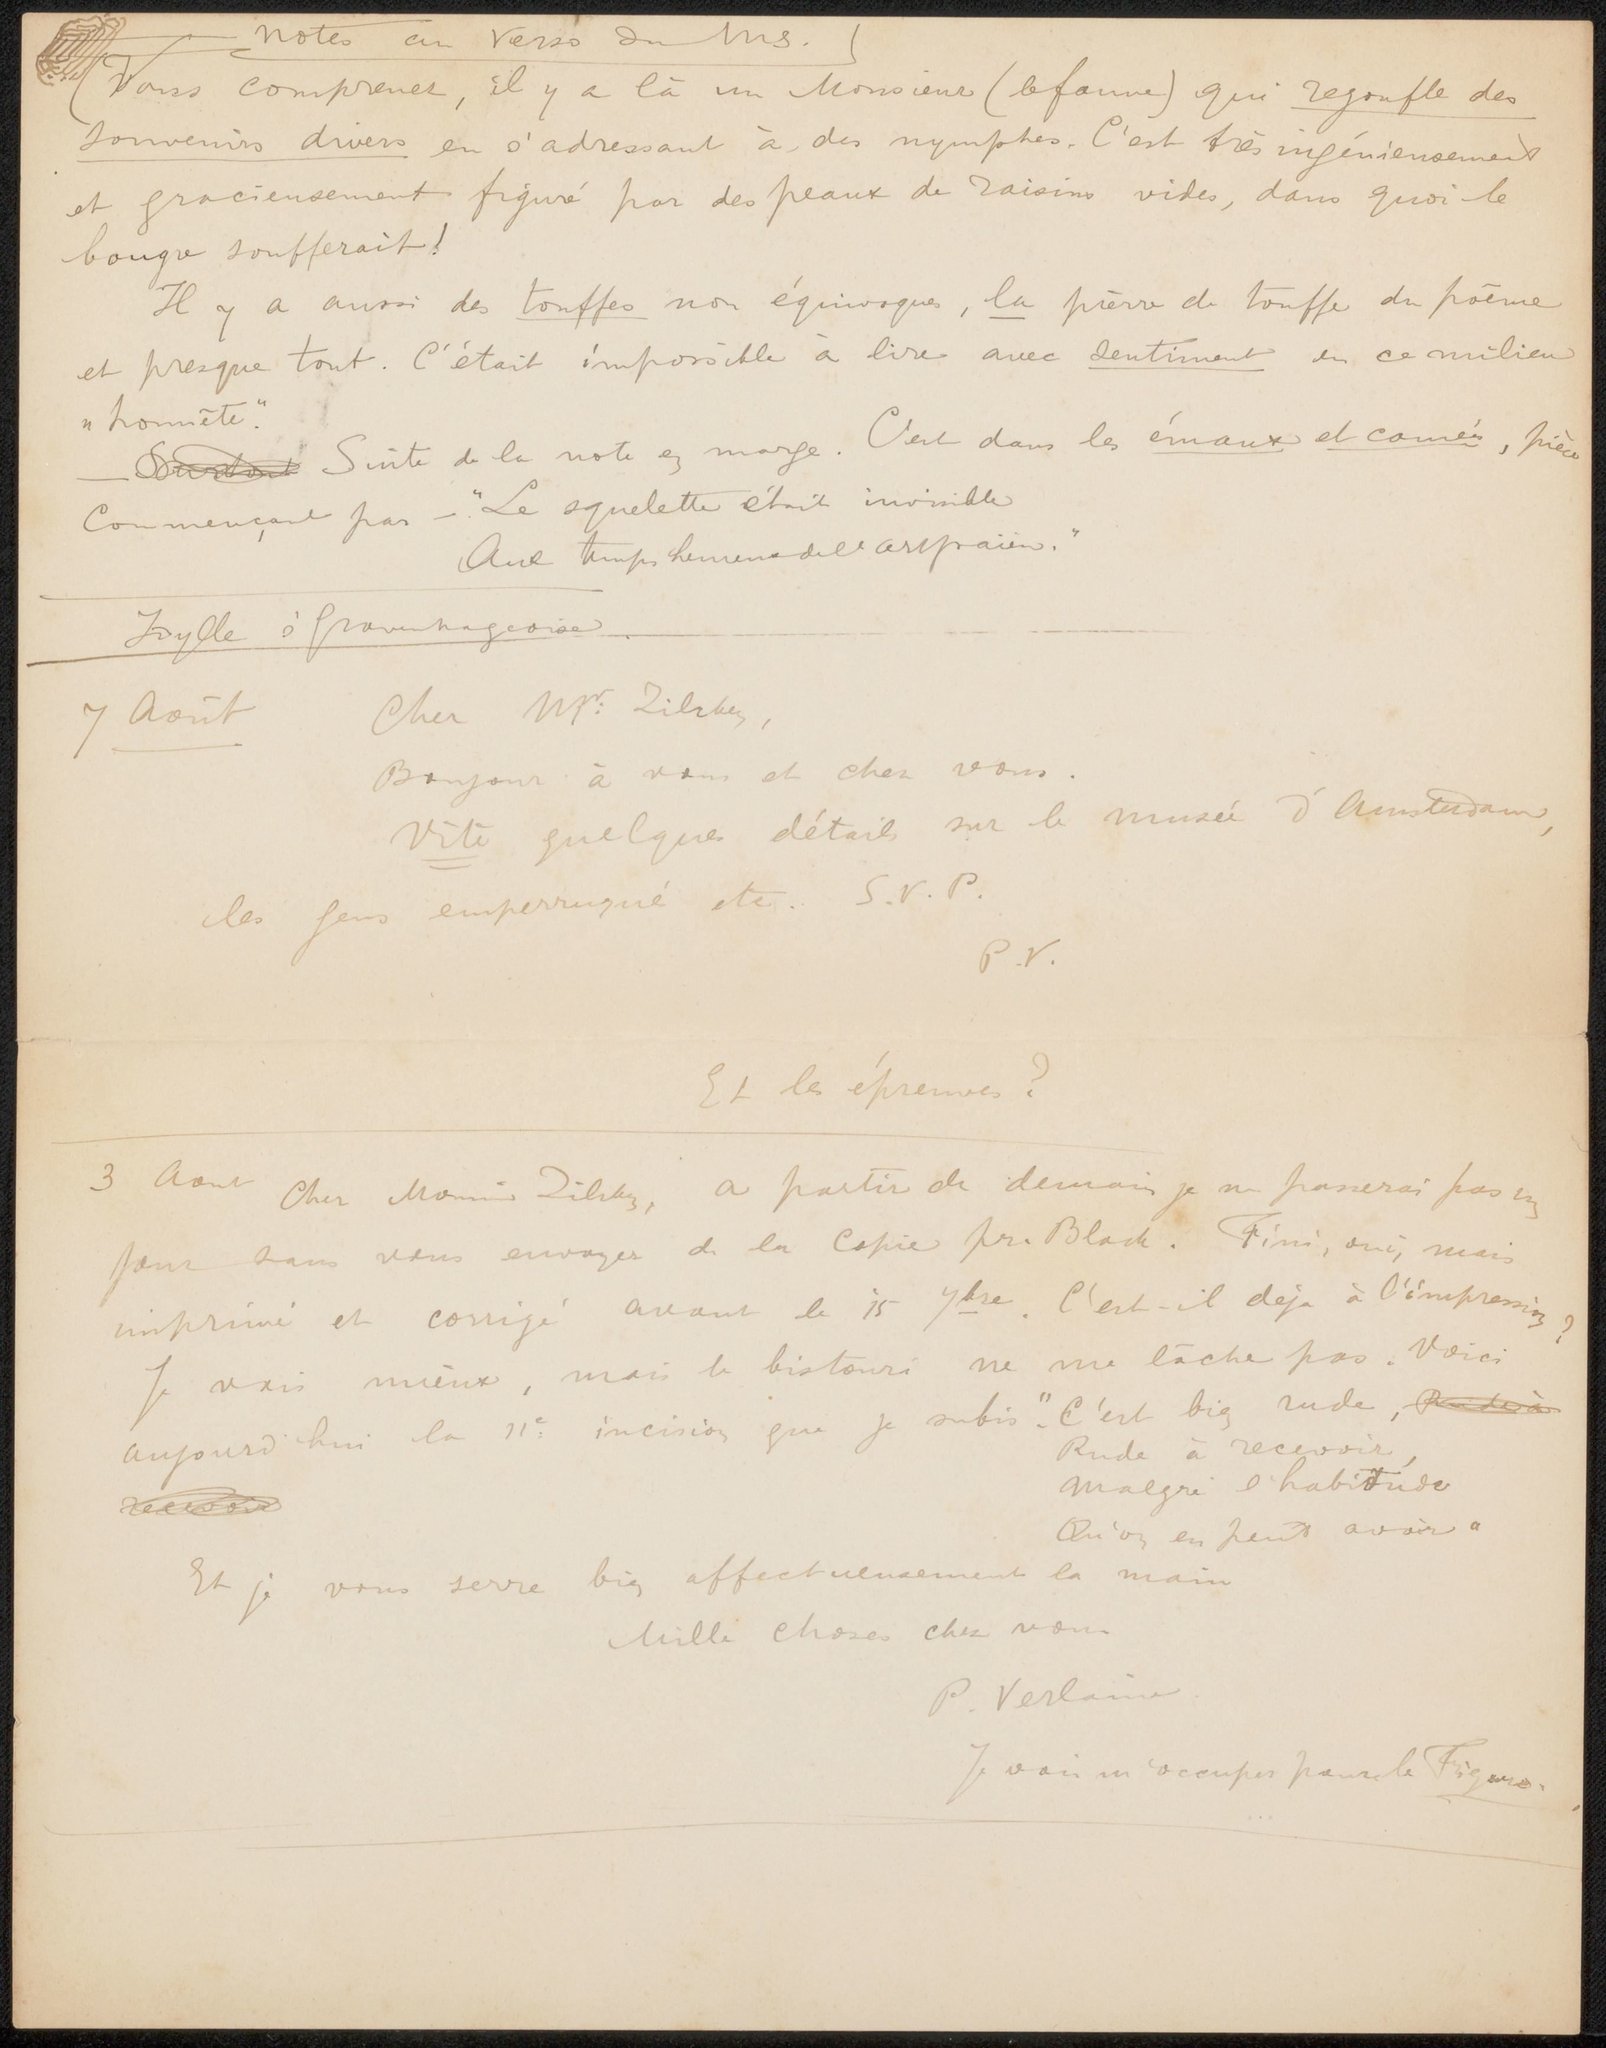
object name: letter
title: Brief aan Philip Zilcken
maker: paul verlaine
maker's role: dichter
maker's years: 1844-1896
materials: ink, paper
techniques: pen, printing, writing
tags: the hague, publisher, rijksmuseum amsterdam, painter, draughtsman, philip zilcken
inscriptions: collector's mark: ‘RPK’